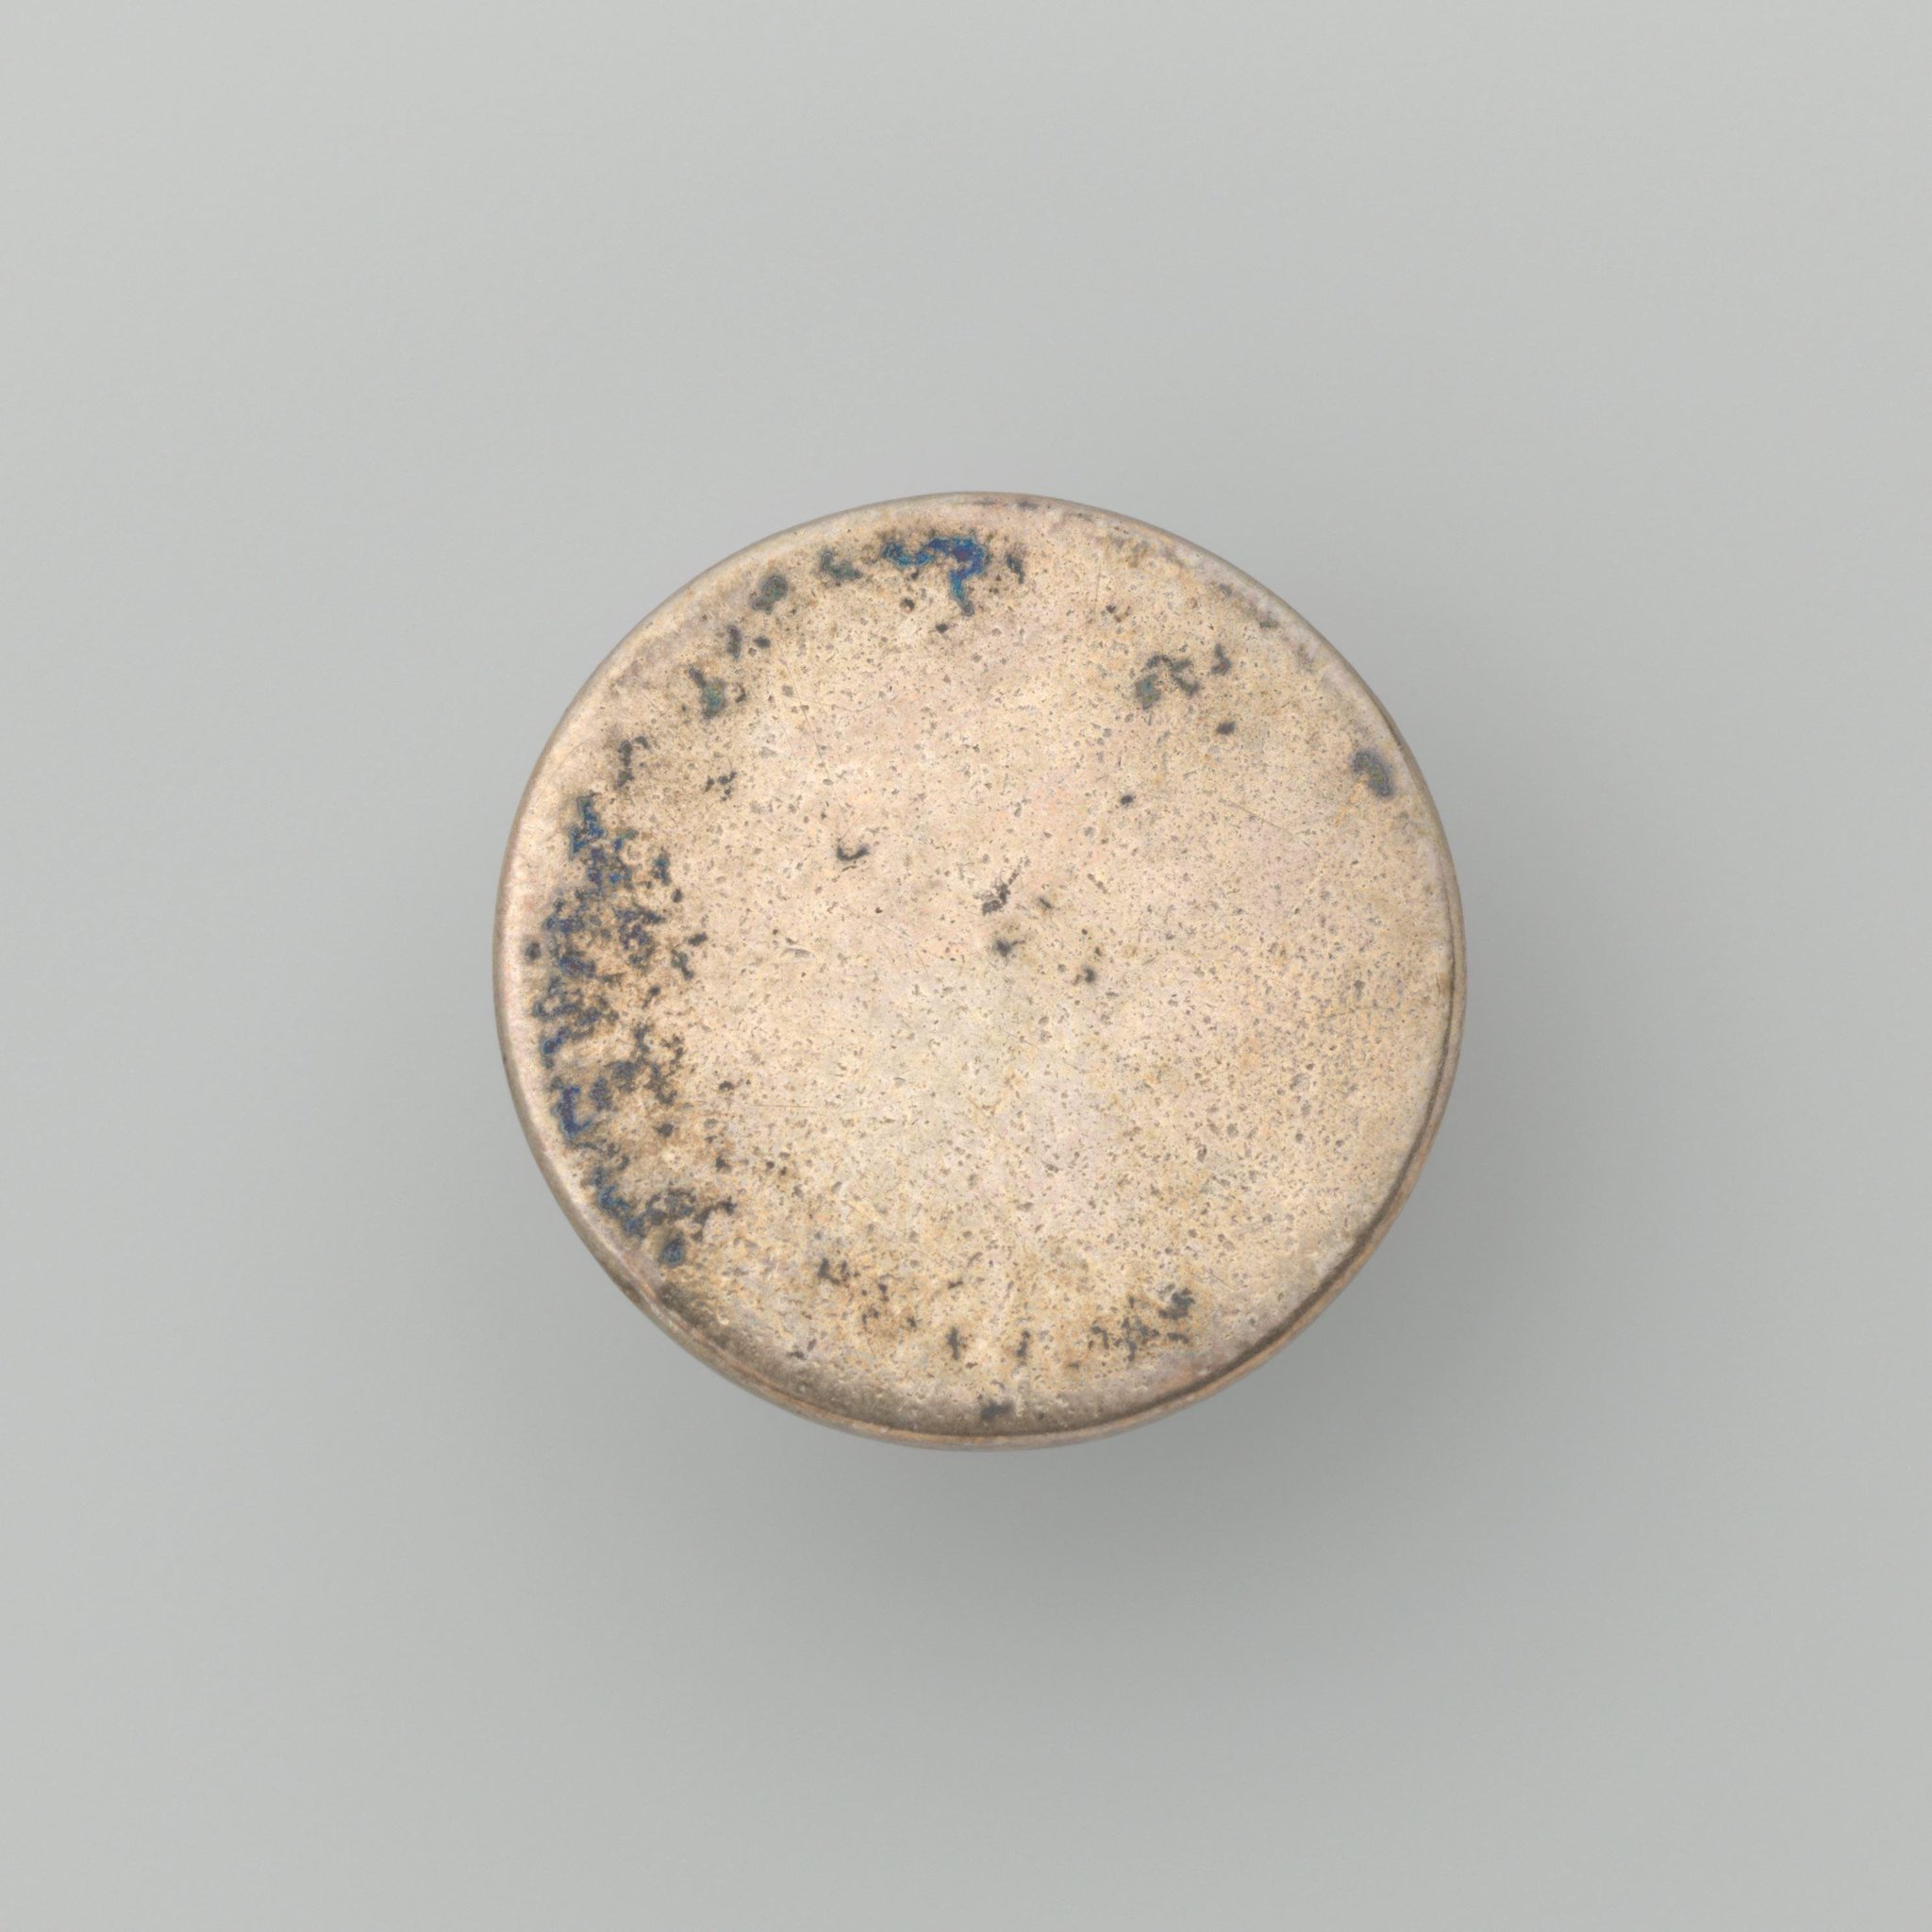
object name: button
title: Knoop van zilver, van een jachtwambuis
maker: jacob helweg (ii)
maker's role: silversmith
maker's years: 1798-1875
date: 1822-1853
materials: silver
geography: amsterdam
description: Knoop van zilver, van een jachtwambuis ten tijde van Koning Willem II. Model: rond, plat en met een oog. Merken: mt. nr. 4117 (= J. Helweg). Amsterdam, ca. 1825-1850.